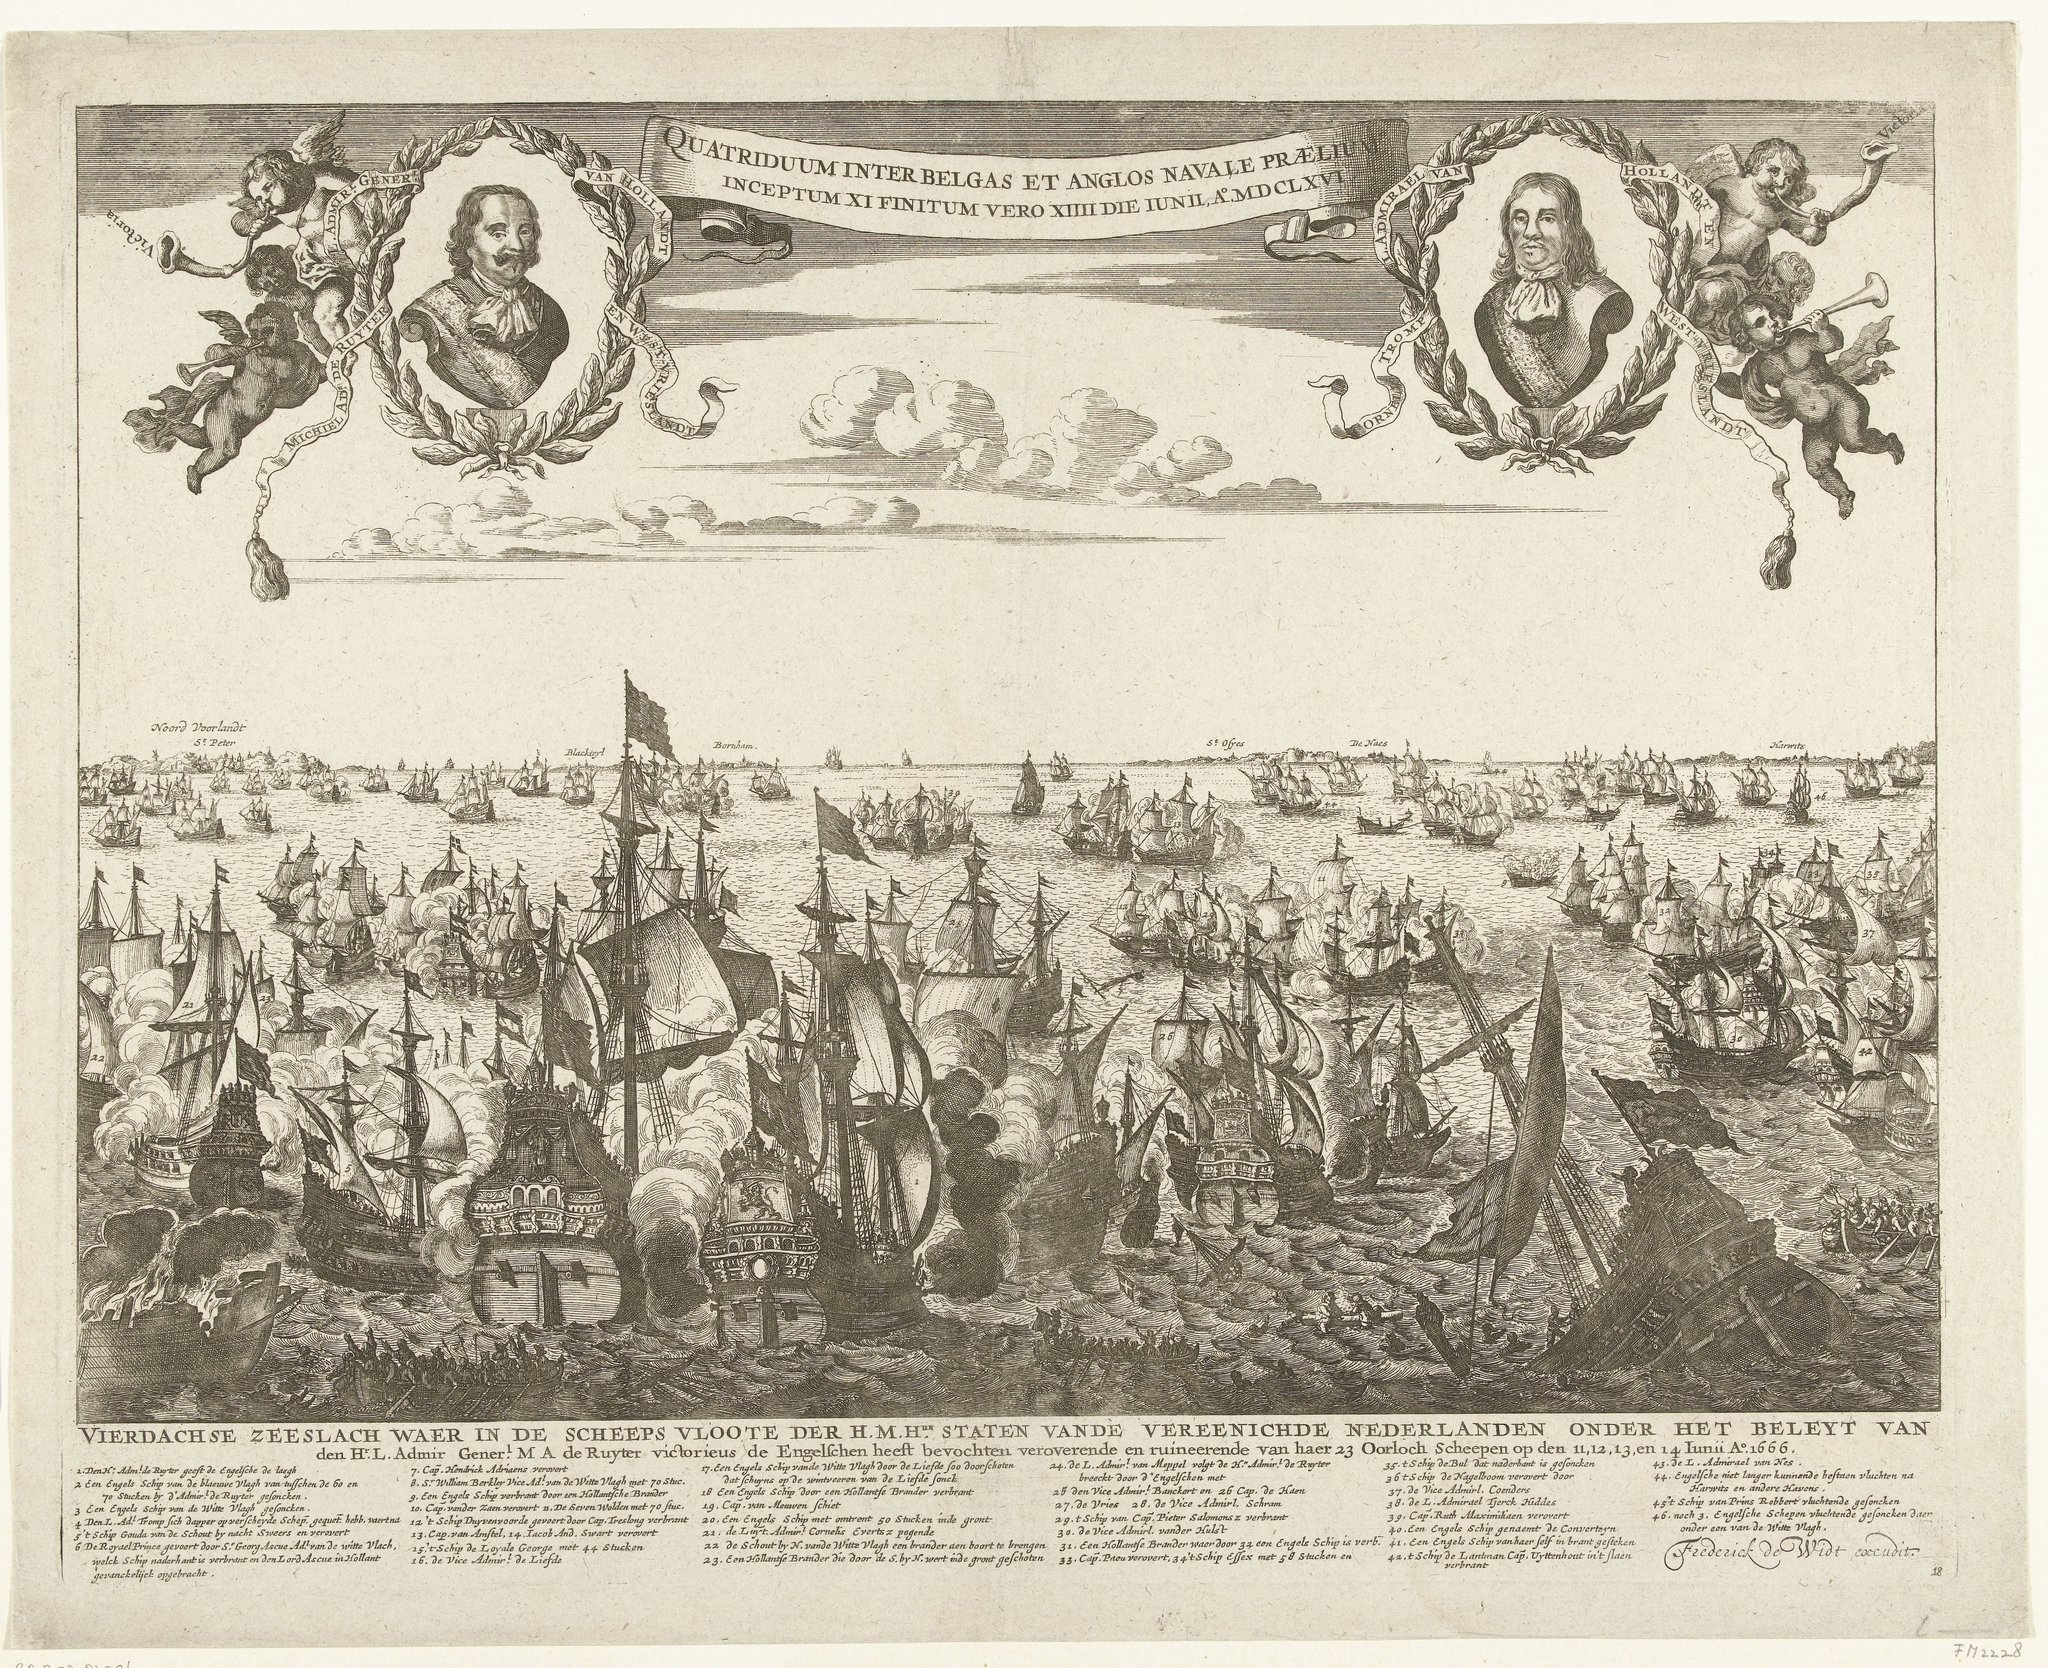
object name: print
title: Vierdachse zeeslach, waer in de scheeps vloote der H.M. Hrn. Staten van de Vereenichde Nederlanden onder het beleyt van den Hr. L. Admir Gener.l M.A. de Ruyter victorieus de Engelschen heeft bevochten veroverende en ruineerende van haer 23 Oorloch Scheepen op den 11, 12, 13, en 14 Junii Ao. 1666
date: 1666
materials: paper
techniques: etching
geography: amsterdam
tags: flushing, michiel adriaenszoon de ruyter, rotterdam, amsterdam, cornelis tromp, battle (+ naval force)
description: De Vierdaagse Zeeslag tussen de Staatse vloot onder admiraal Michiel Adriaenszoon de Ruyter en de Engelse vloot onder admiraal George Monck, 11-14 juni 1666. In de lucht de portretten van De Ruyter en Cornelis Tromp in lauwerkransen met engeltjes met bazuinen. Op de achtergrond de Engelse kust. In het onderschrift de legenda 1-46. Genummerd rechtsonder: 18.